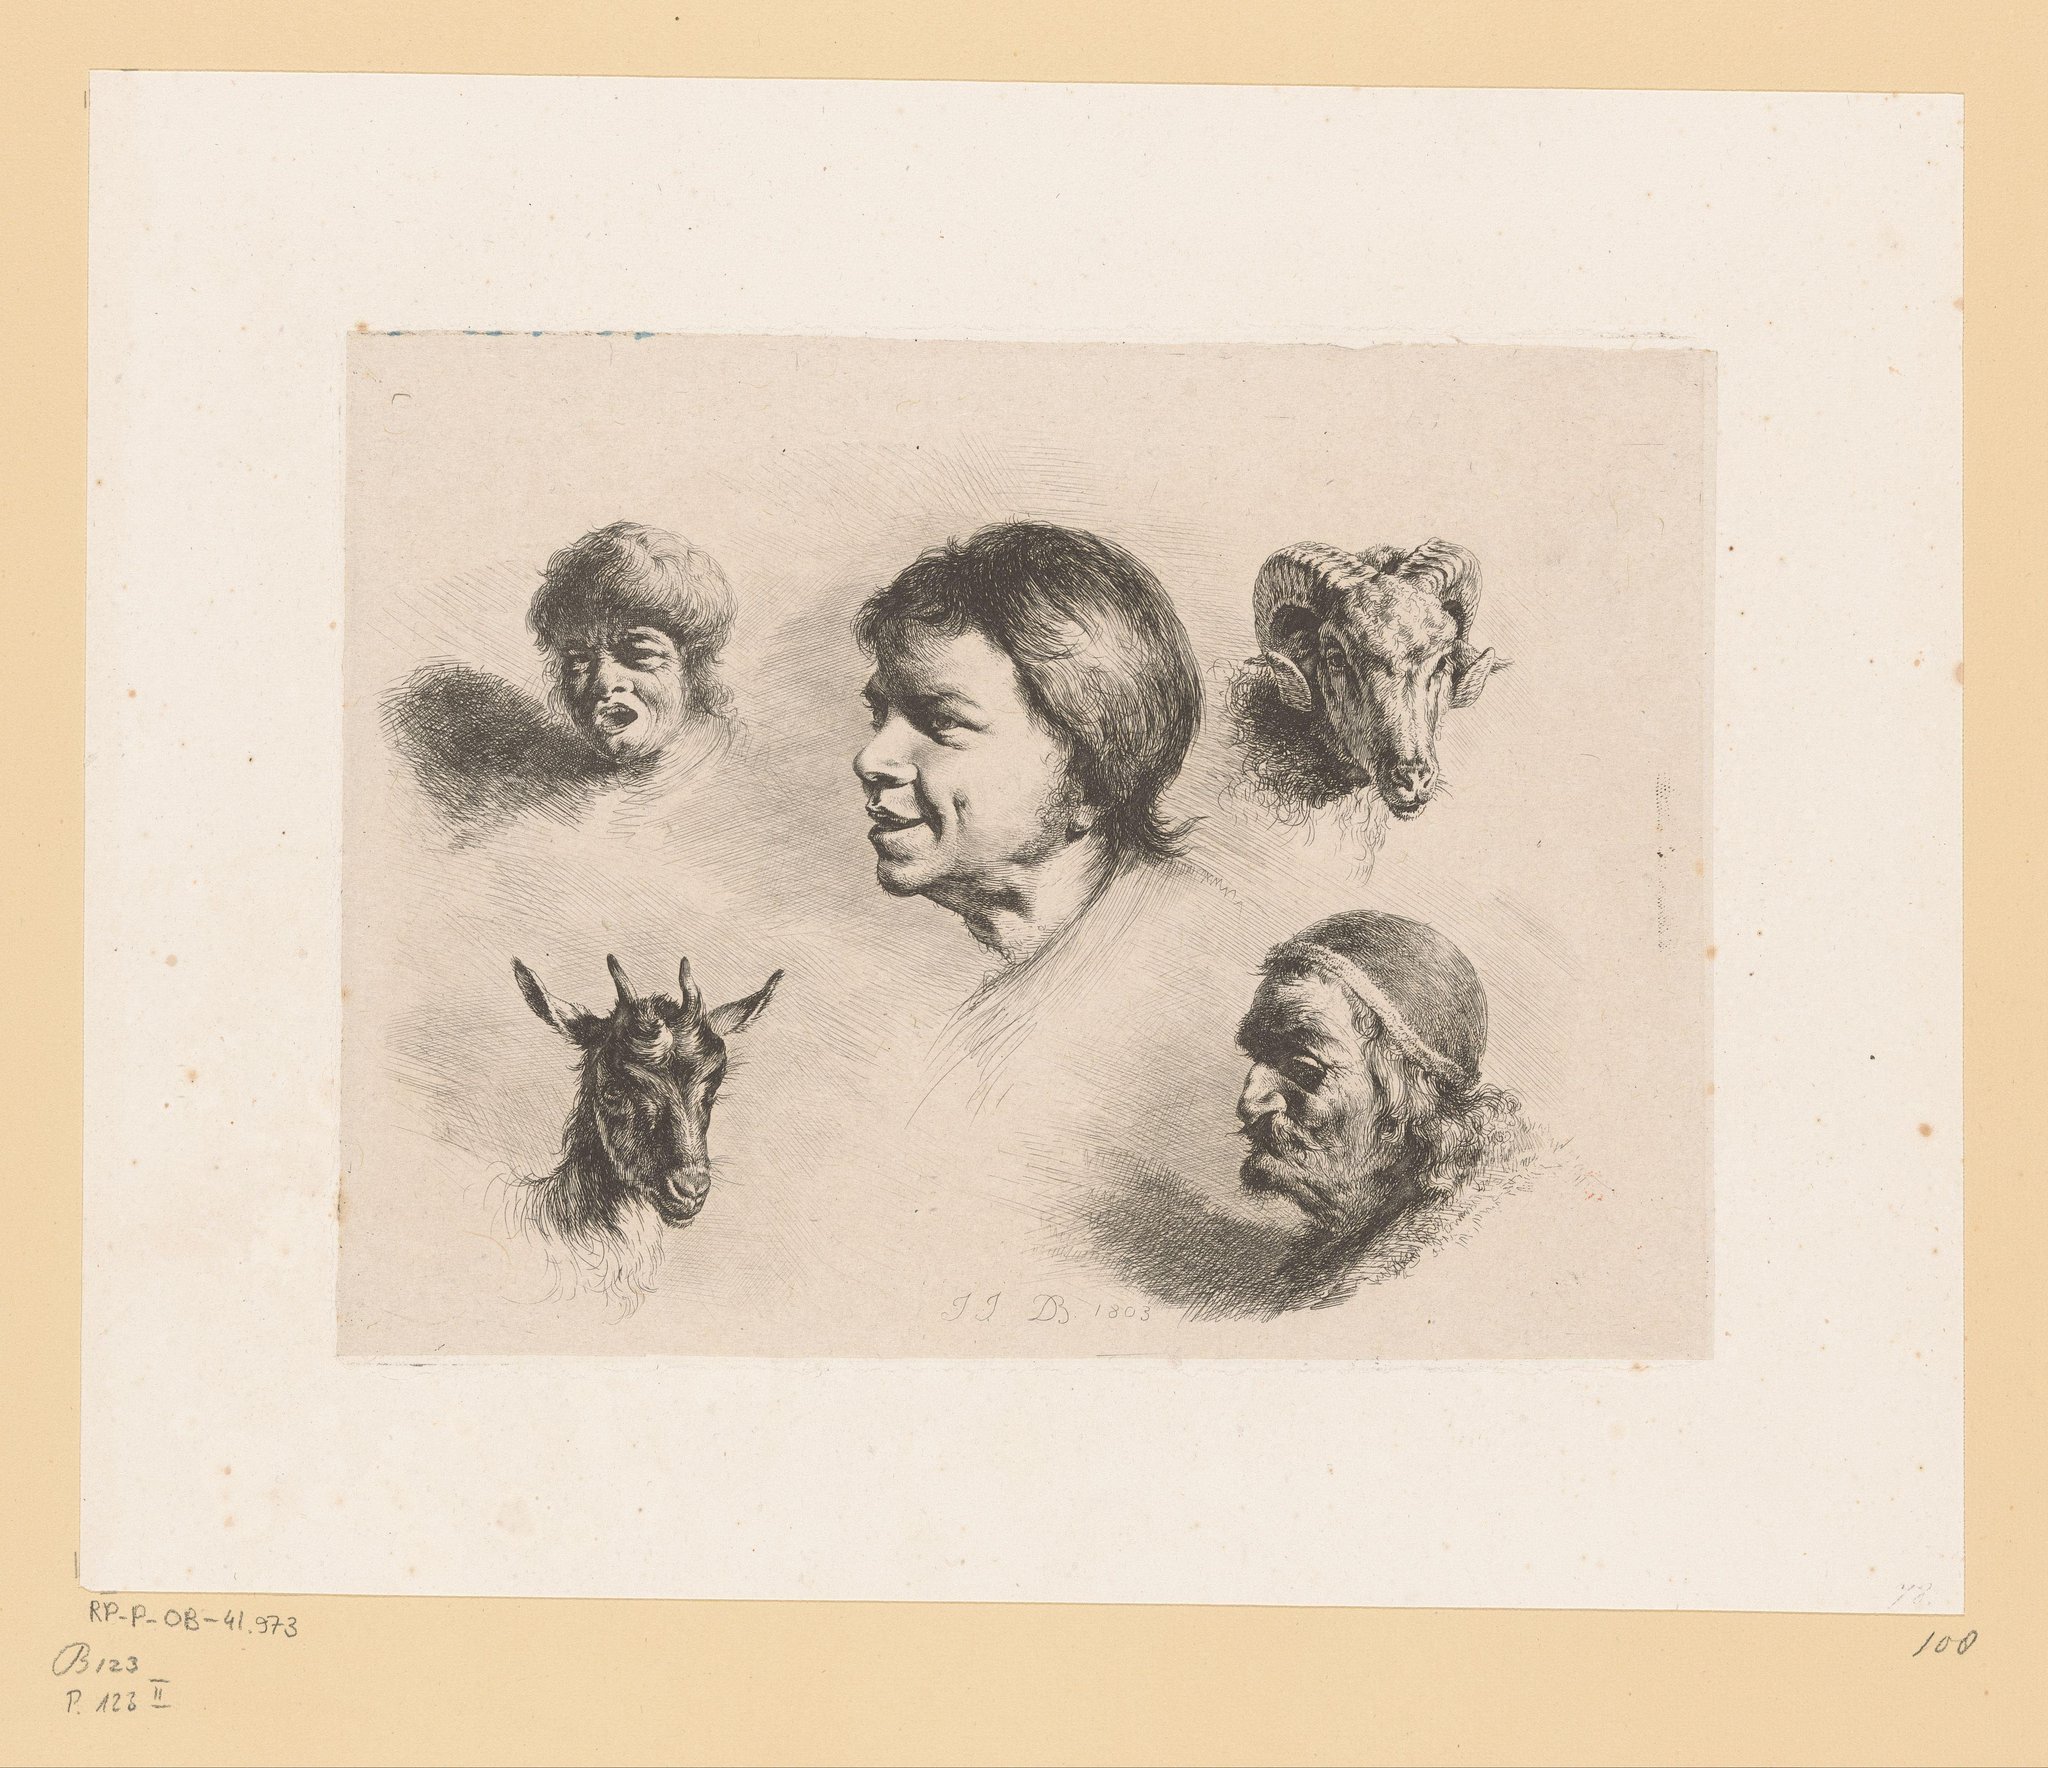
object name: print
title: Compositie met drie hoofden van mannen van verschillende leeftijden, een ram en een bok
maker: jean jacques de boissieu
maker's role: draughtsman, print maker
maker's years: 1736-1810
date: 1803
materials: paper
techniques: drypoint, etching, roulette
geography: france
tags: head (human), ram, he-goat, billy-goat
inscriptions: collector's mark: Lugt 12